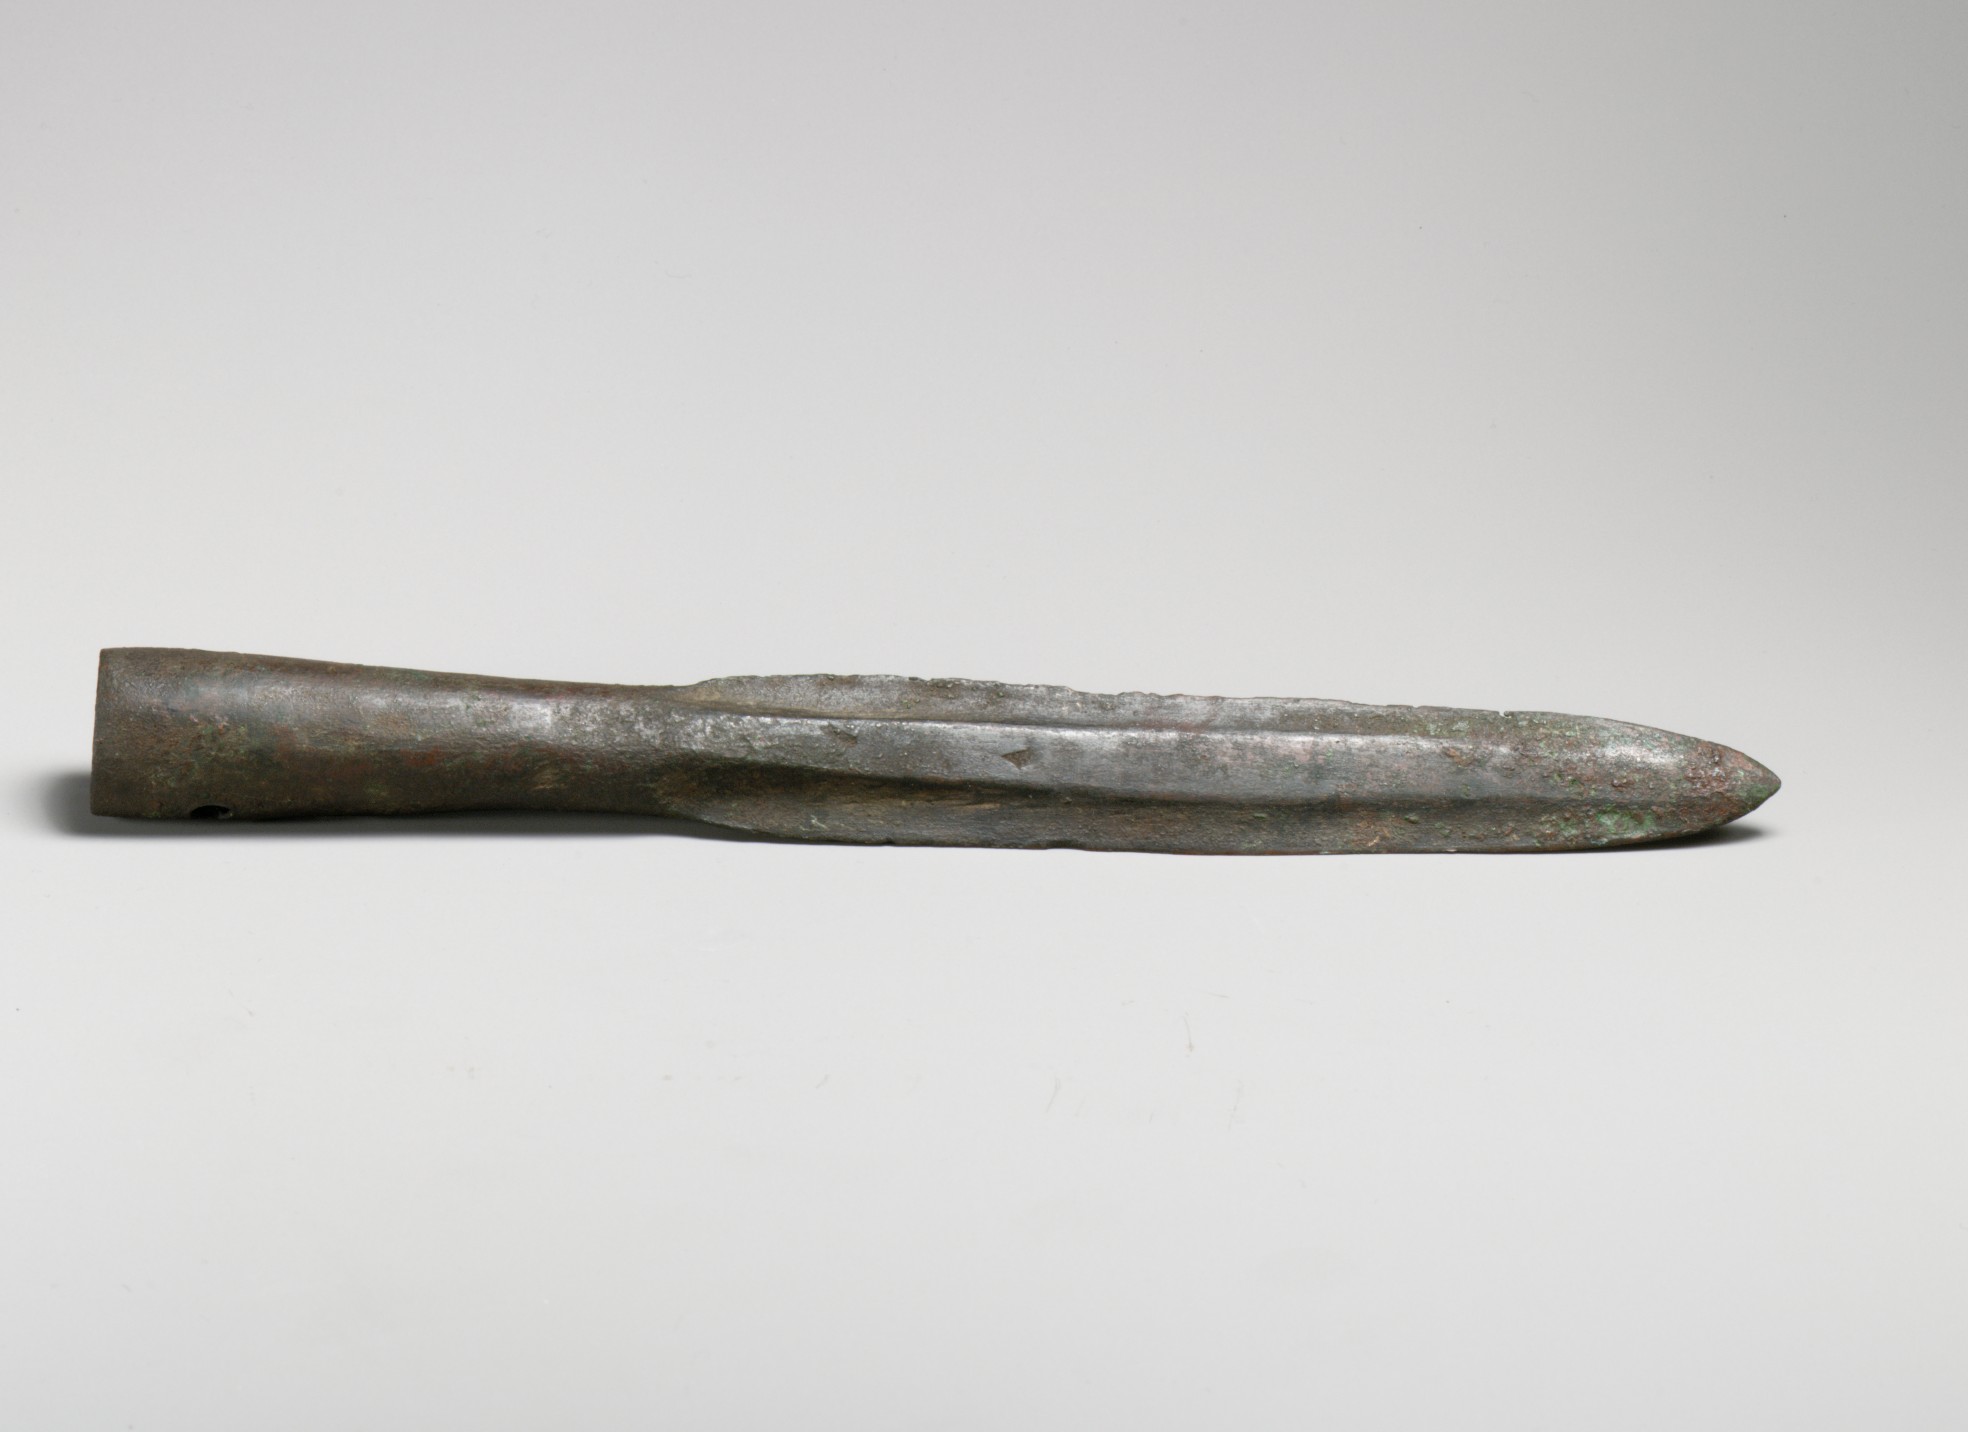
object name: spearhead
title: Bronze spearhead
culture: minoan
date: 1400-1050 BCE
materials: bronze